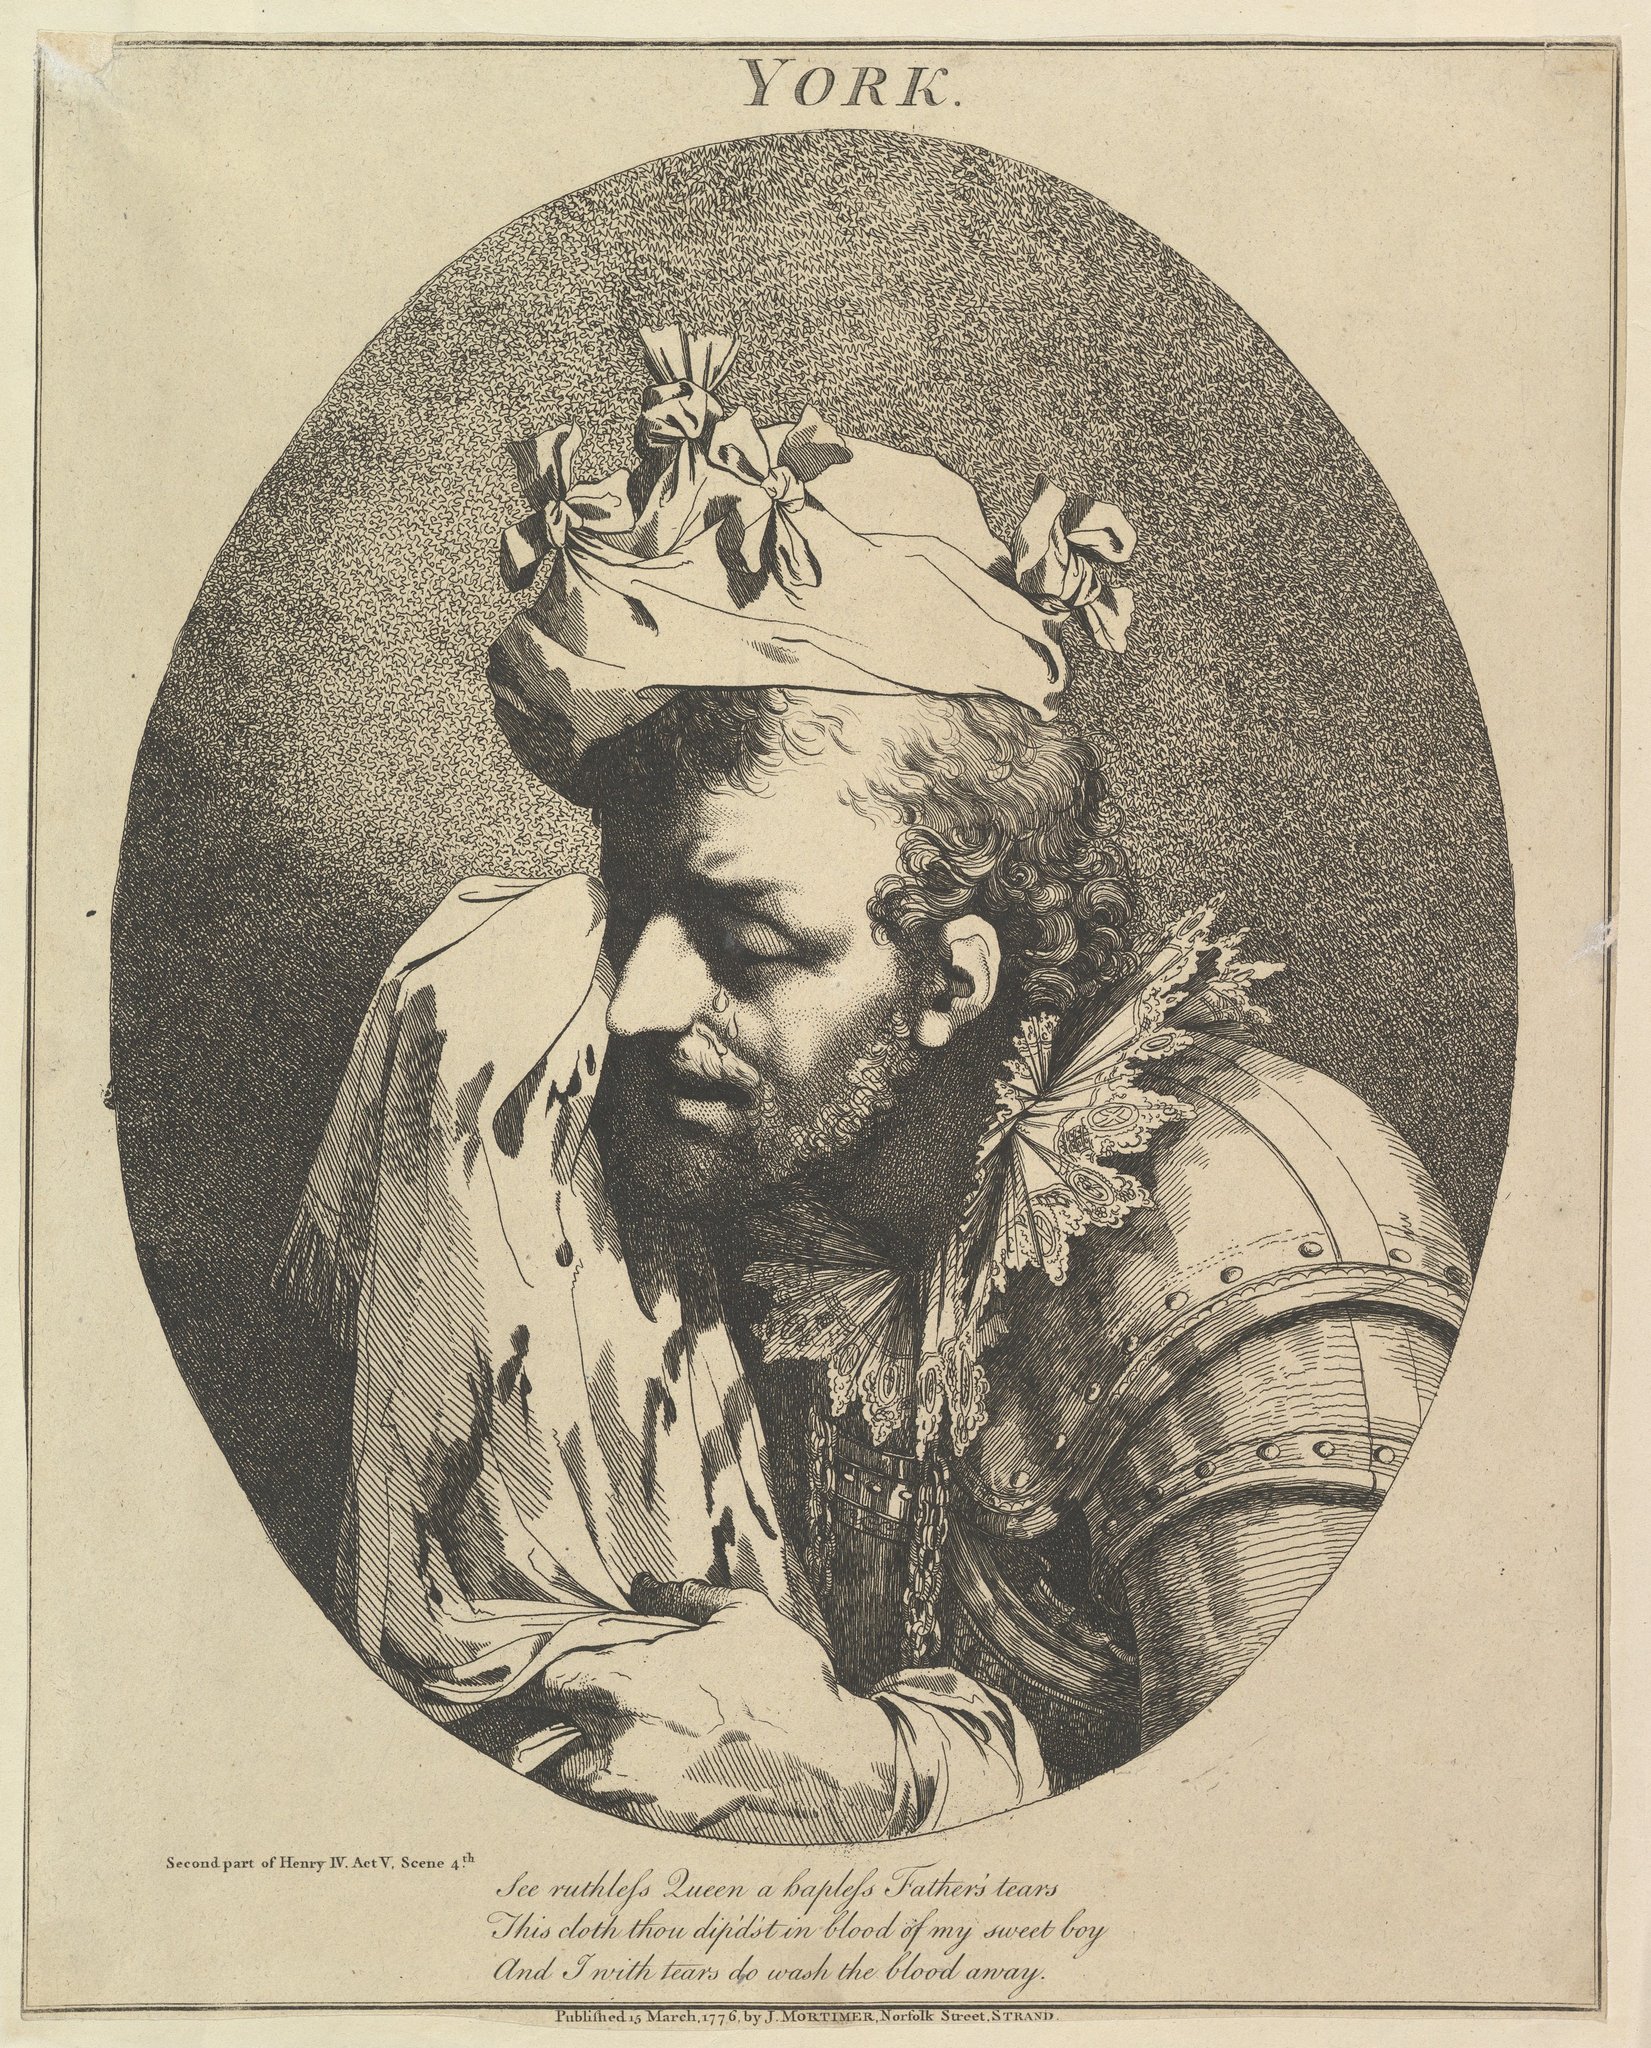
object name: print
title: Duke of York, from "Twelve Characters from Shakespeare"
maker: john hamilton mortimer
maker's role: artist and publisher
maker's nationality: british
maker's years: 1740-1779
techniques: etching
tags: shakespeare,men